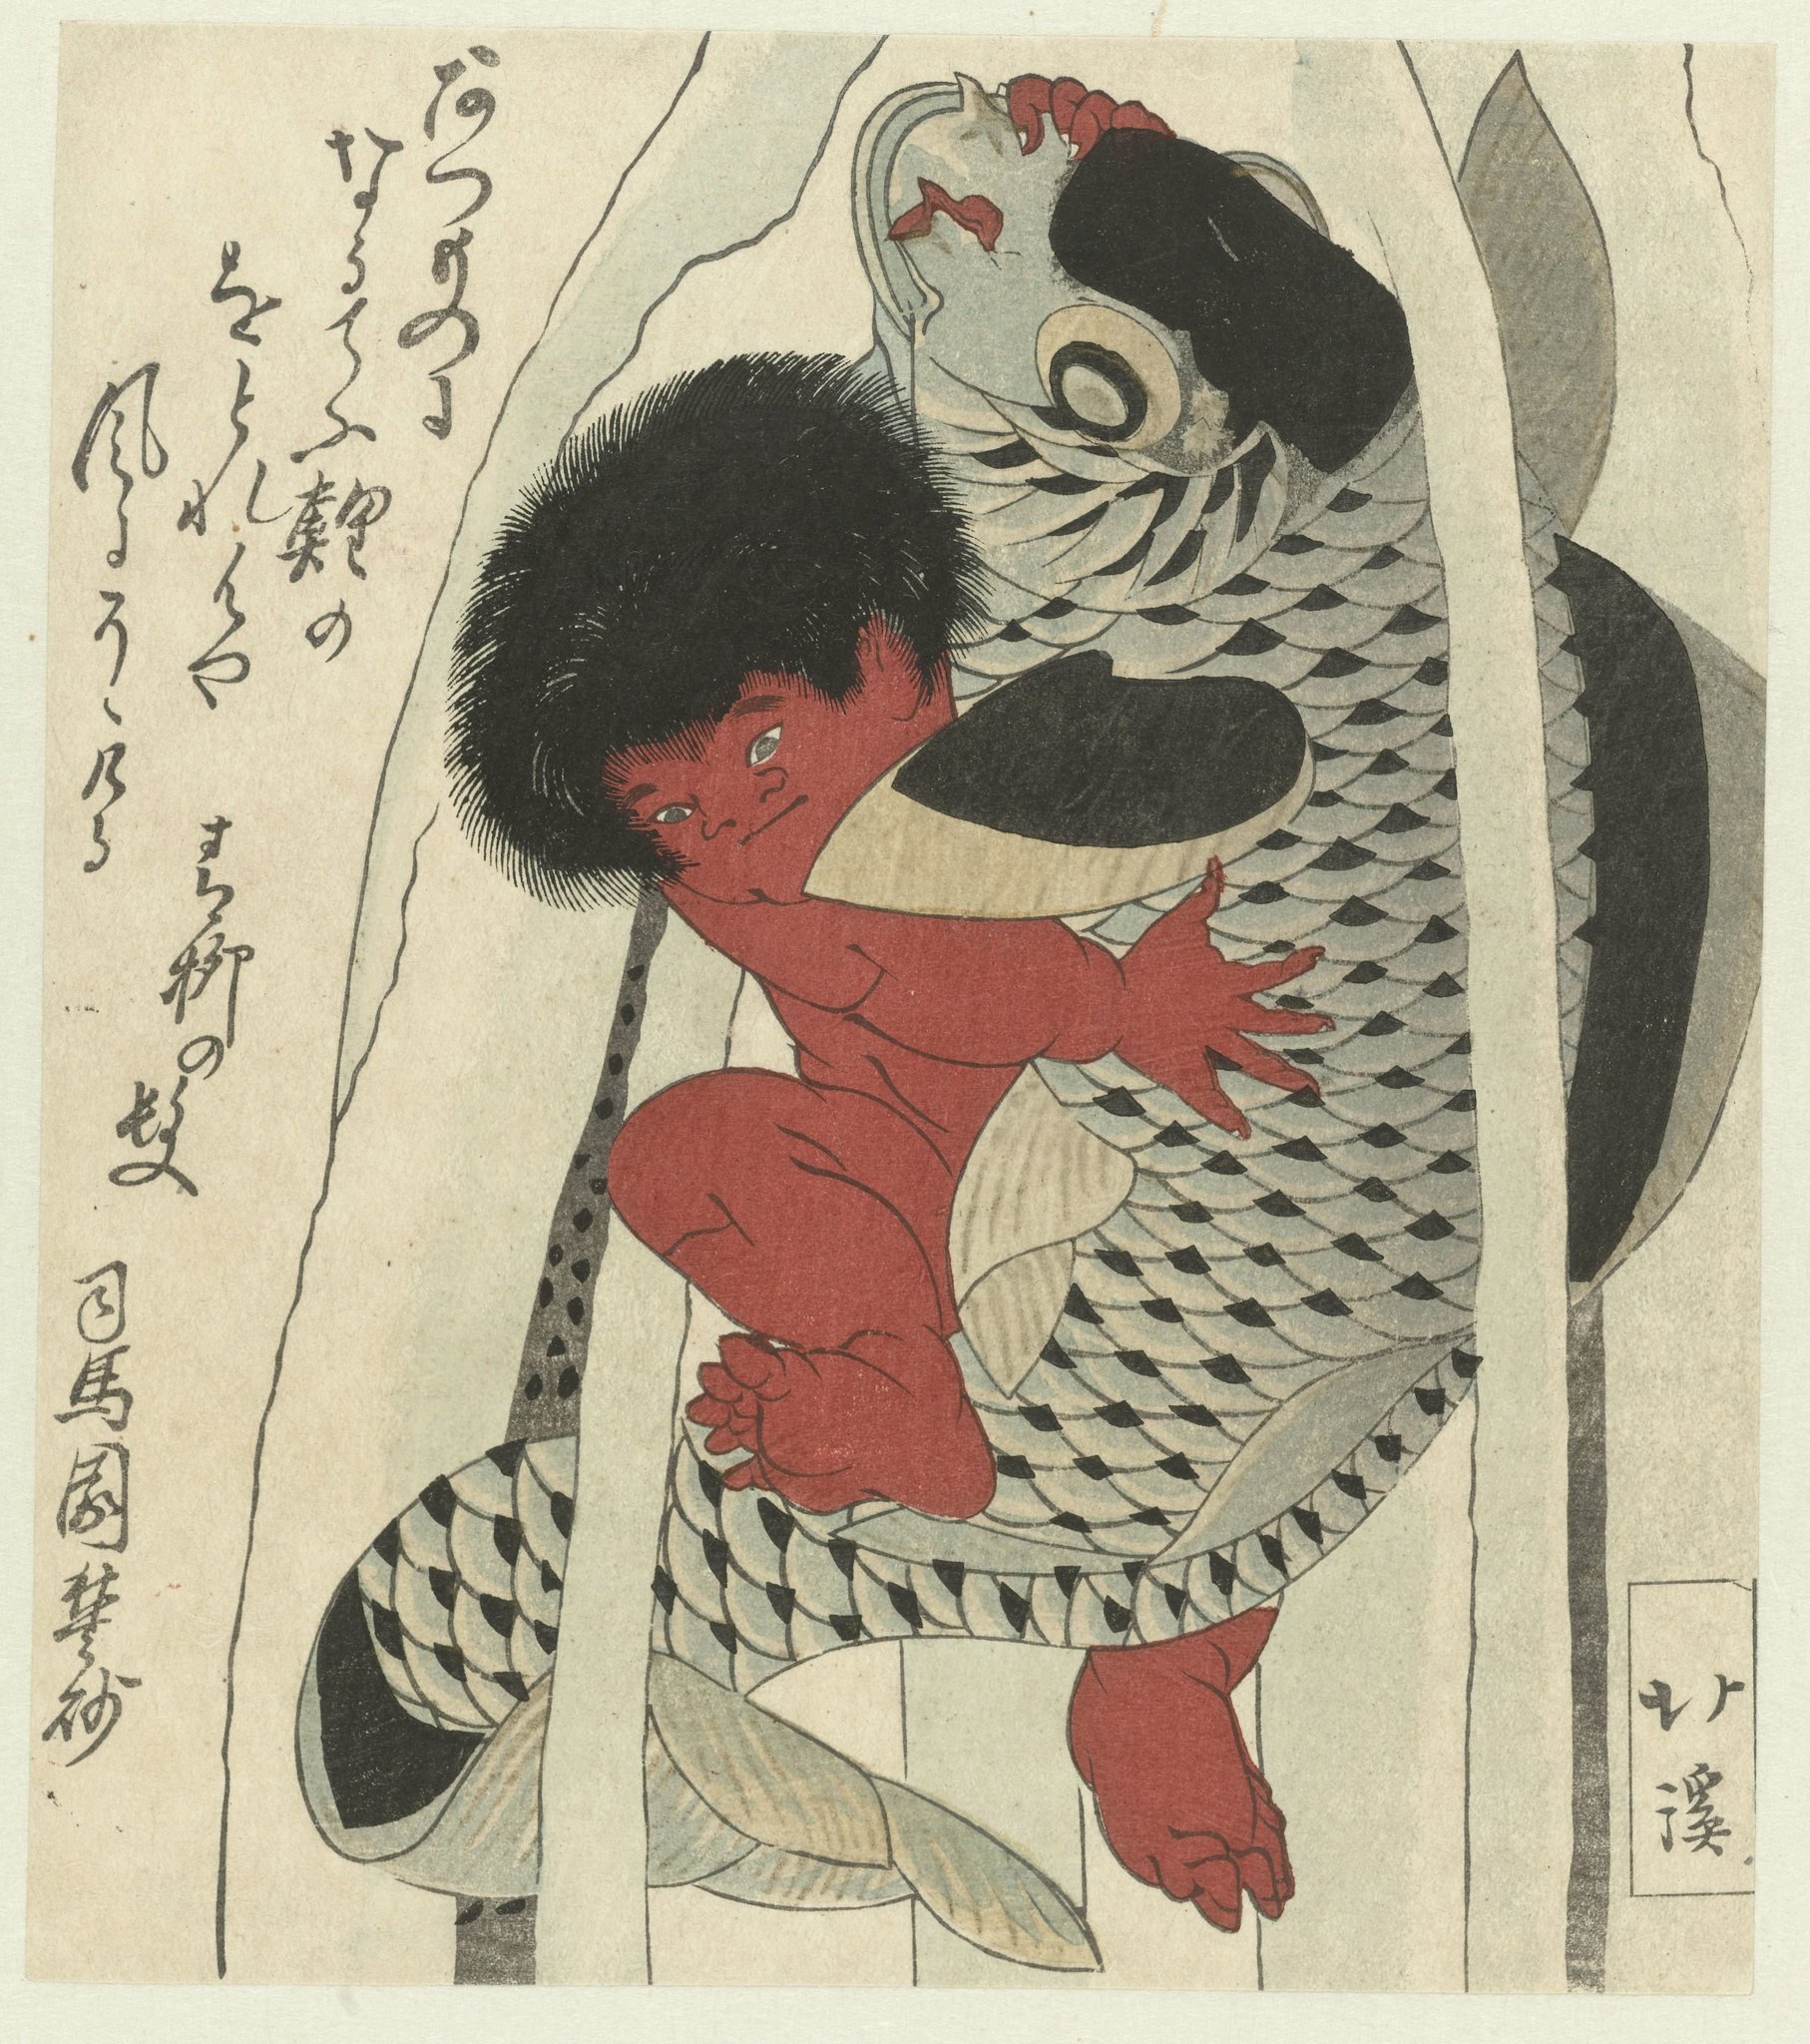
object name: print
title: Kintoki in gevecht met een karper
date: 1800-1850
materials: paper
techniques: woodcut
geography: japan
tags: bony fishes: carp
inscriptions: collector's mark:, collector's mark: Lugt 2228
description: Kintoki worstelt met een karper die tegen een waterval in zwemt. Met één gedicht.